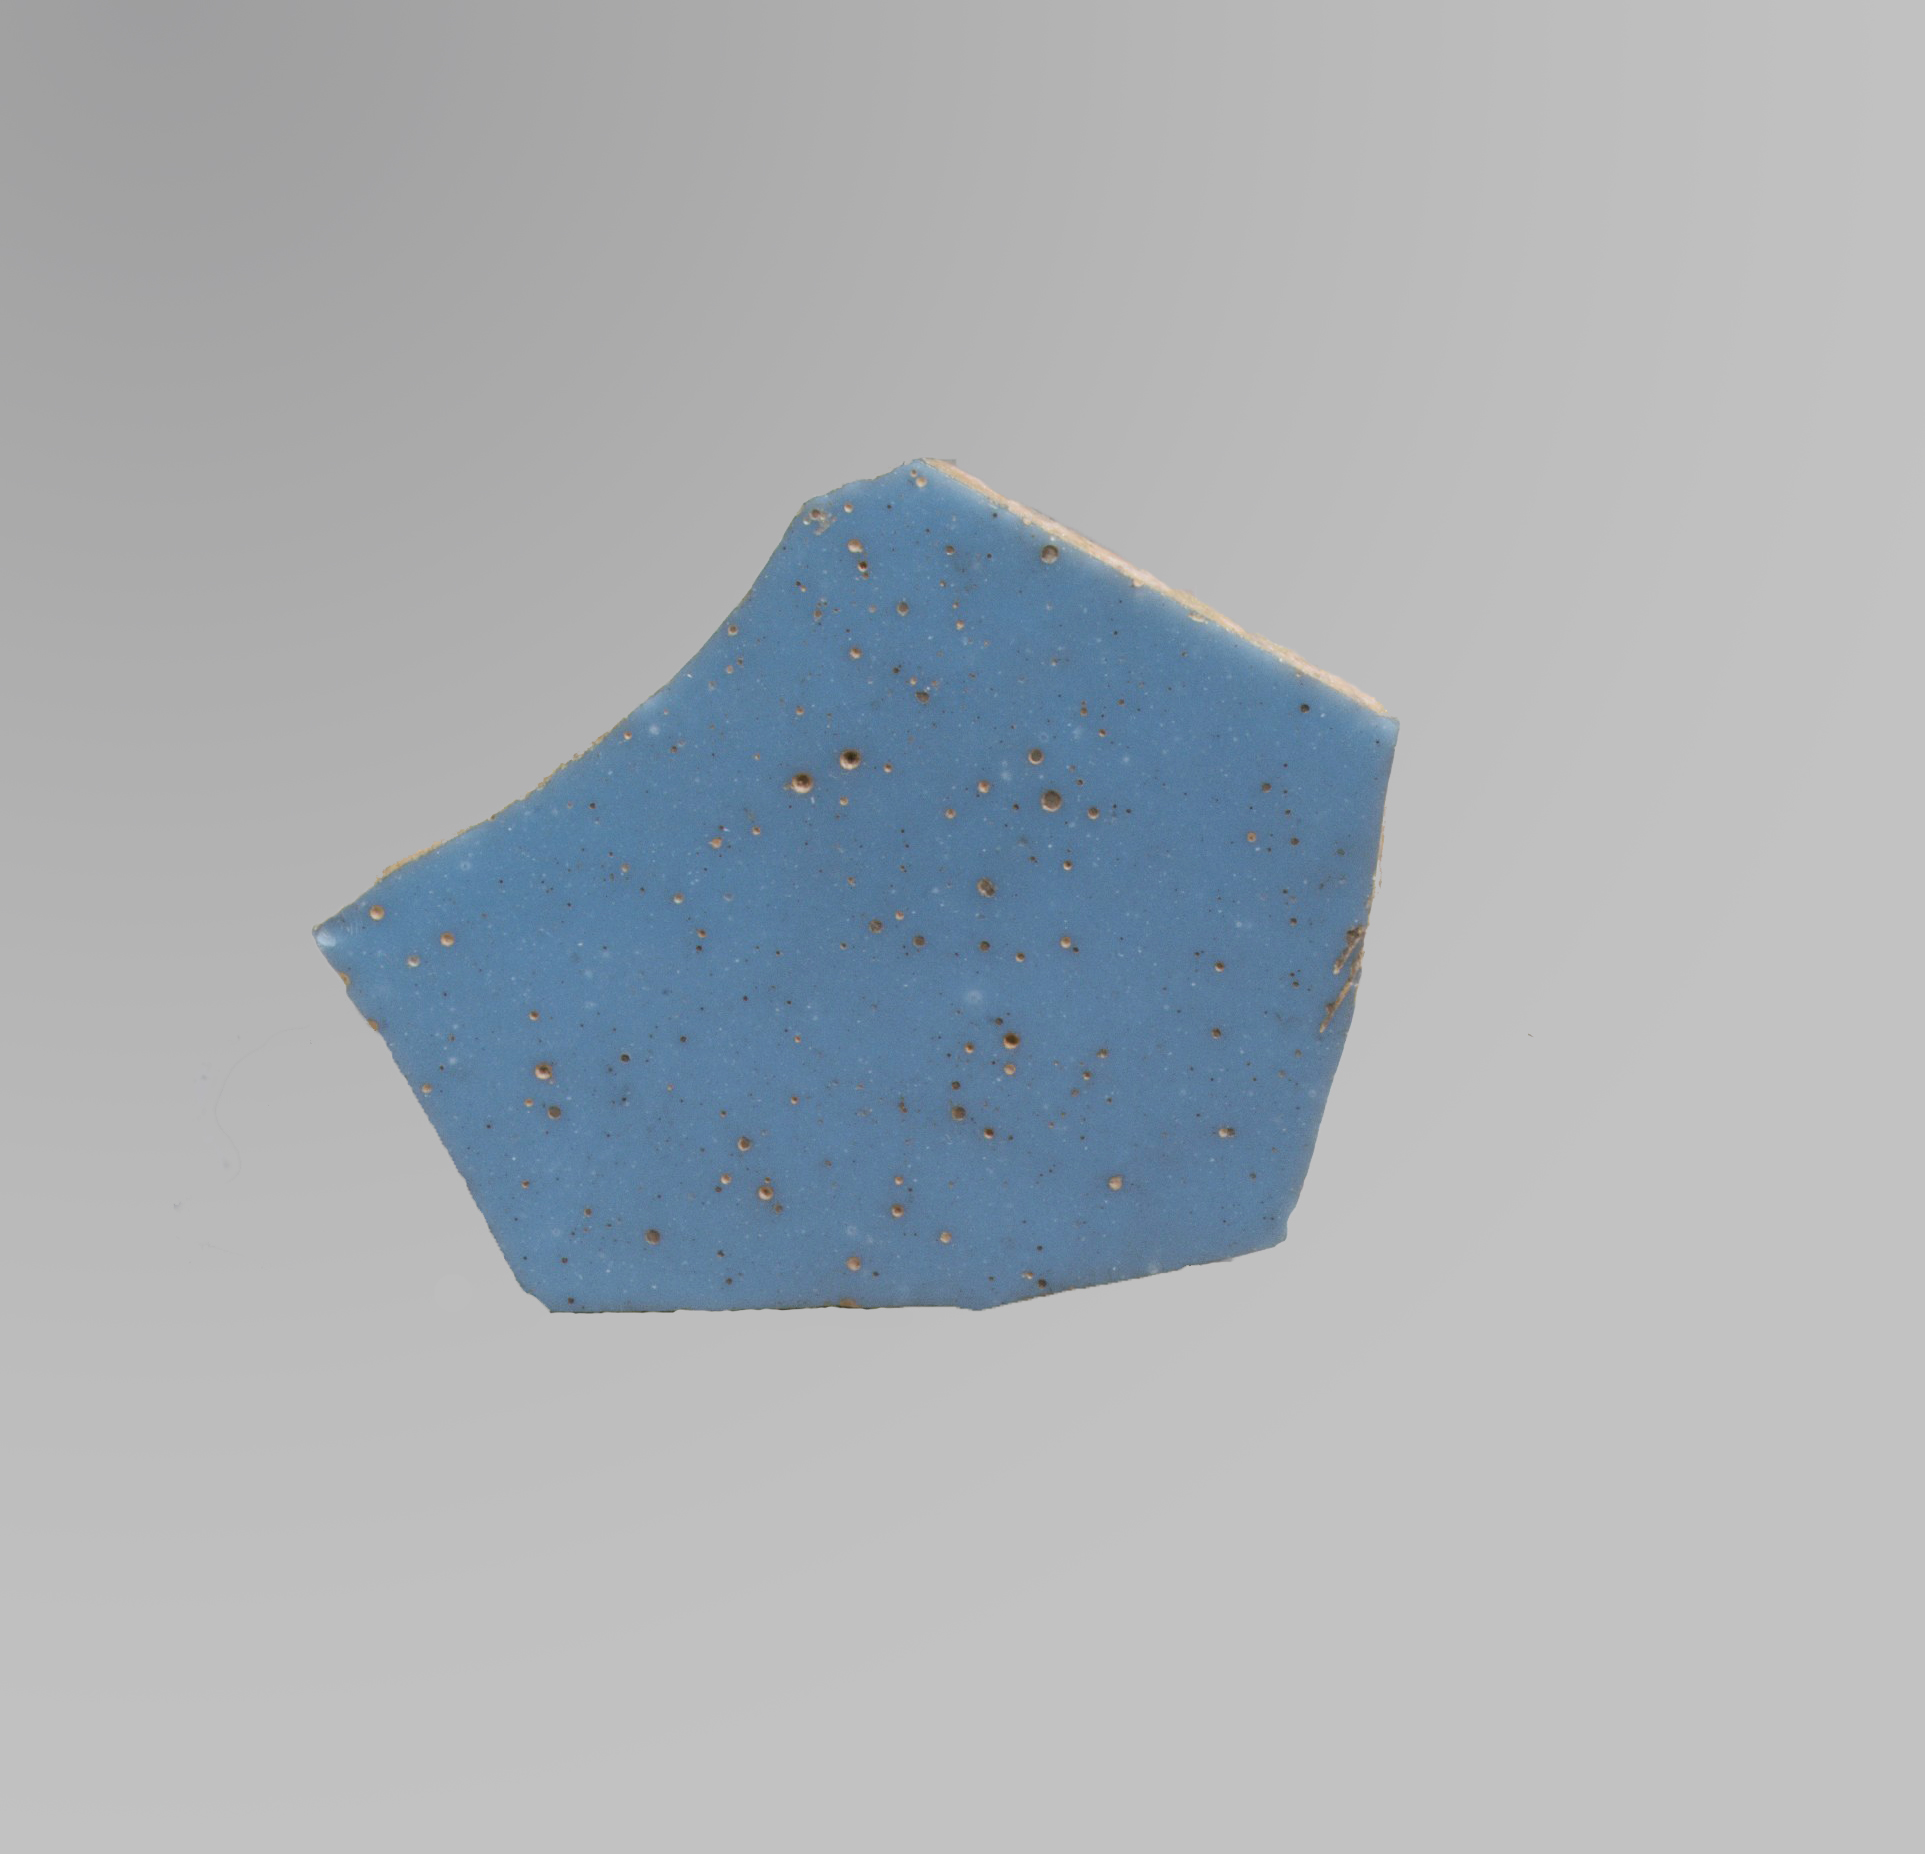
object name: fragment, monochrome inlay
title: Glass monochrome inlay fragment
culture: roman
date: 1-50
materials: glass